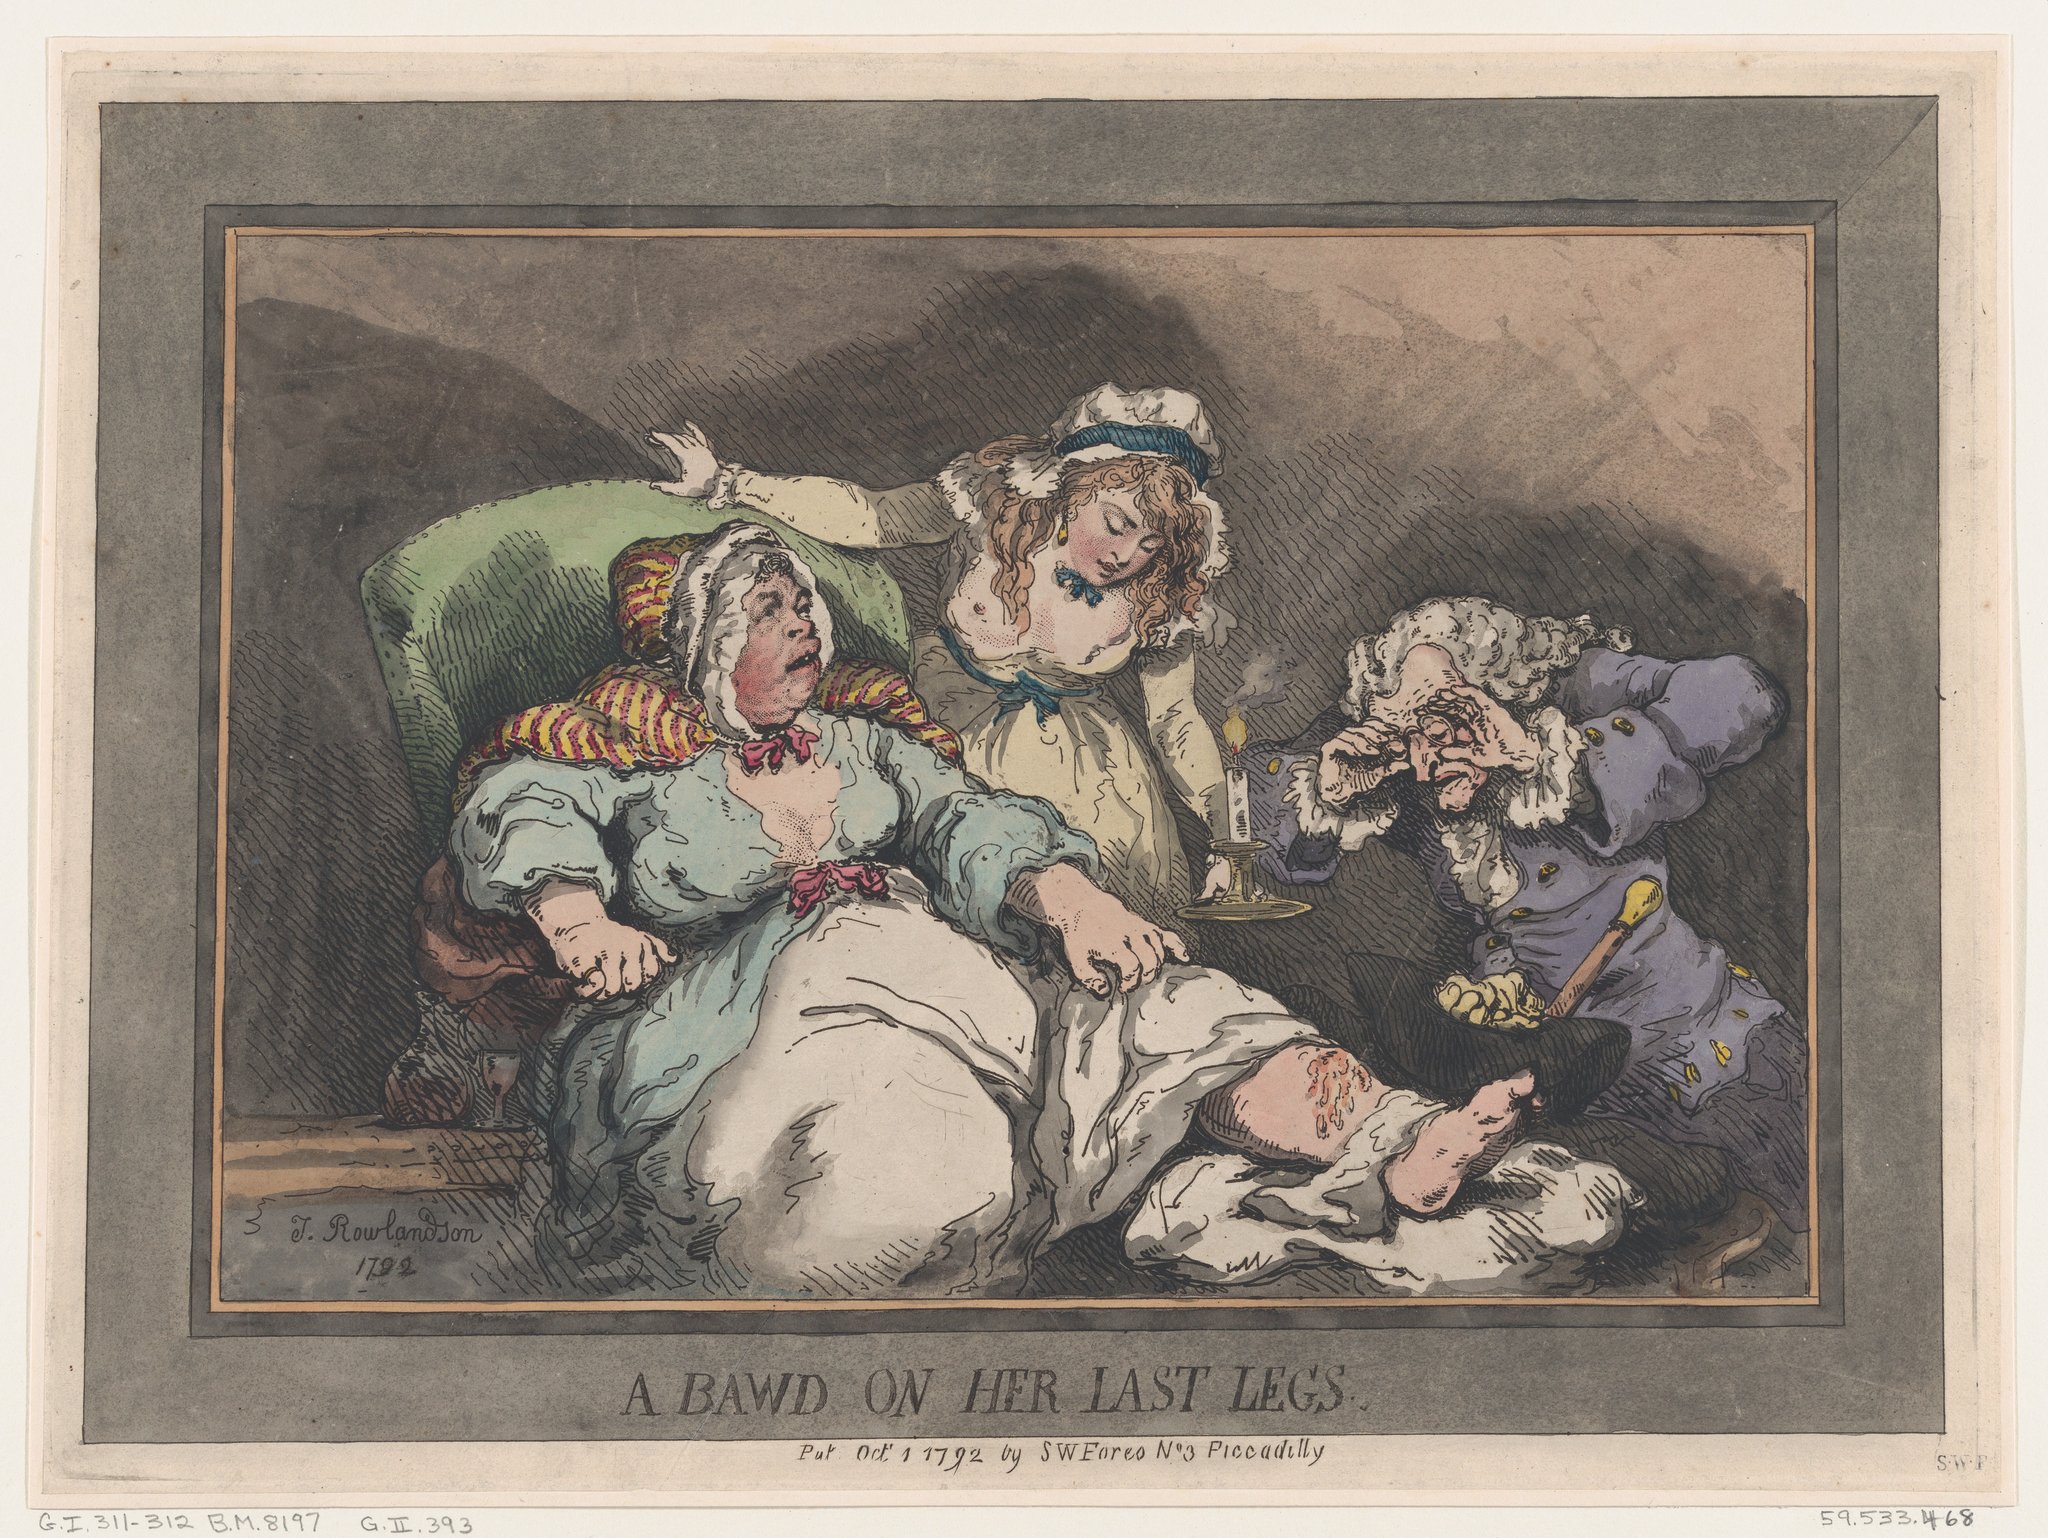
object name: print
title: A Bawd on her Last Legs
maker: thomas rowlandson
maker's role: artist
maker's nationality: british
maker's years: 1757-1827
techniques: etching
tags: satire,men,women